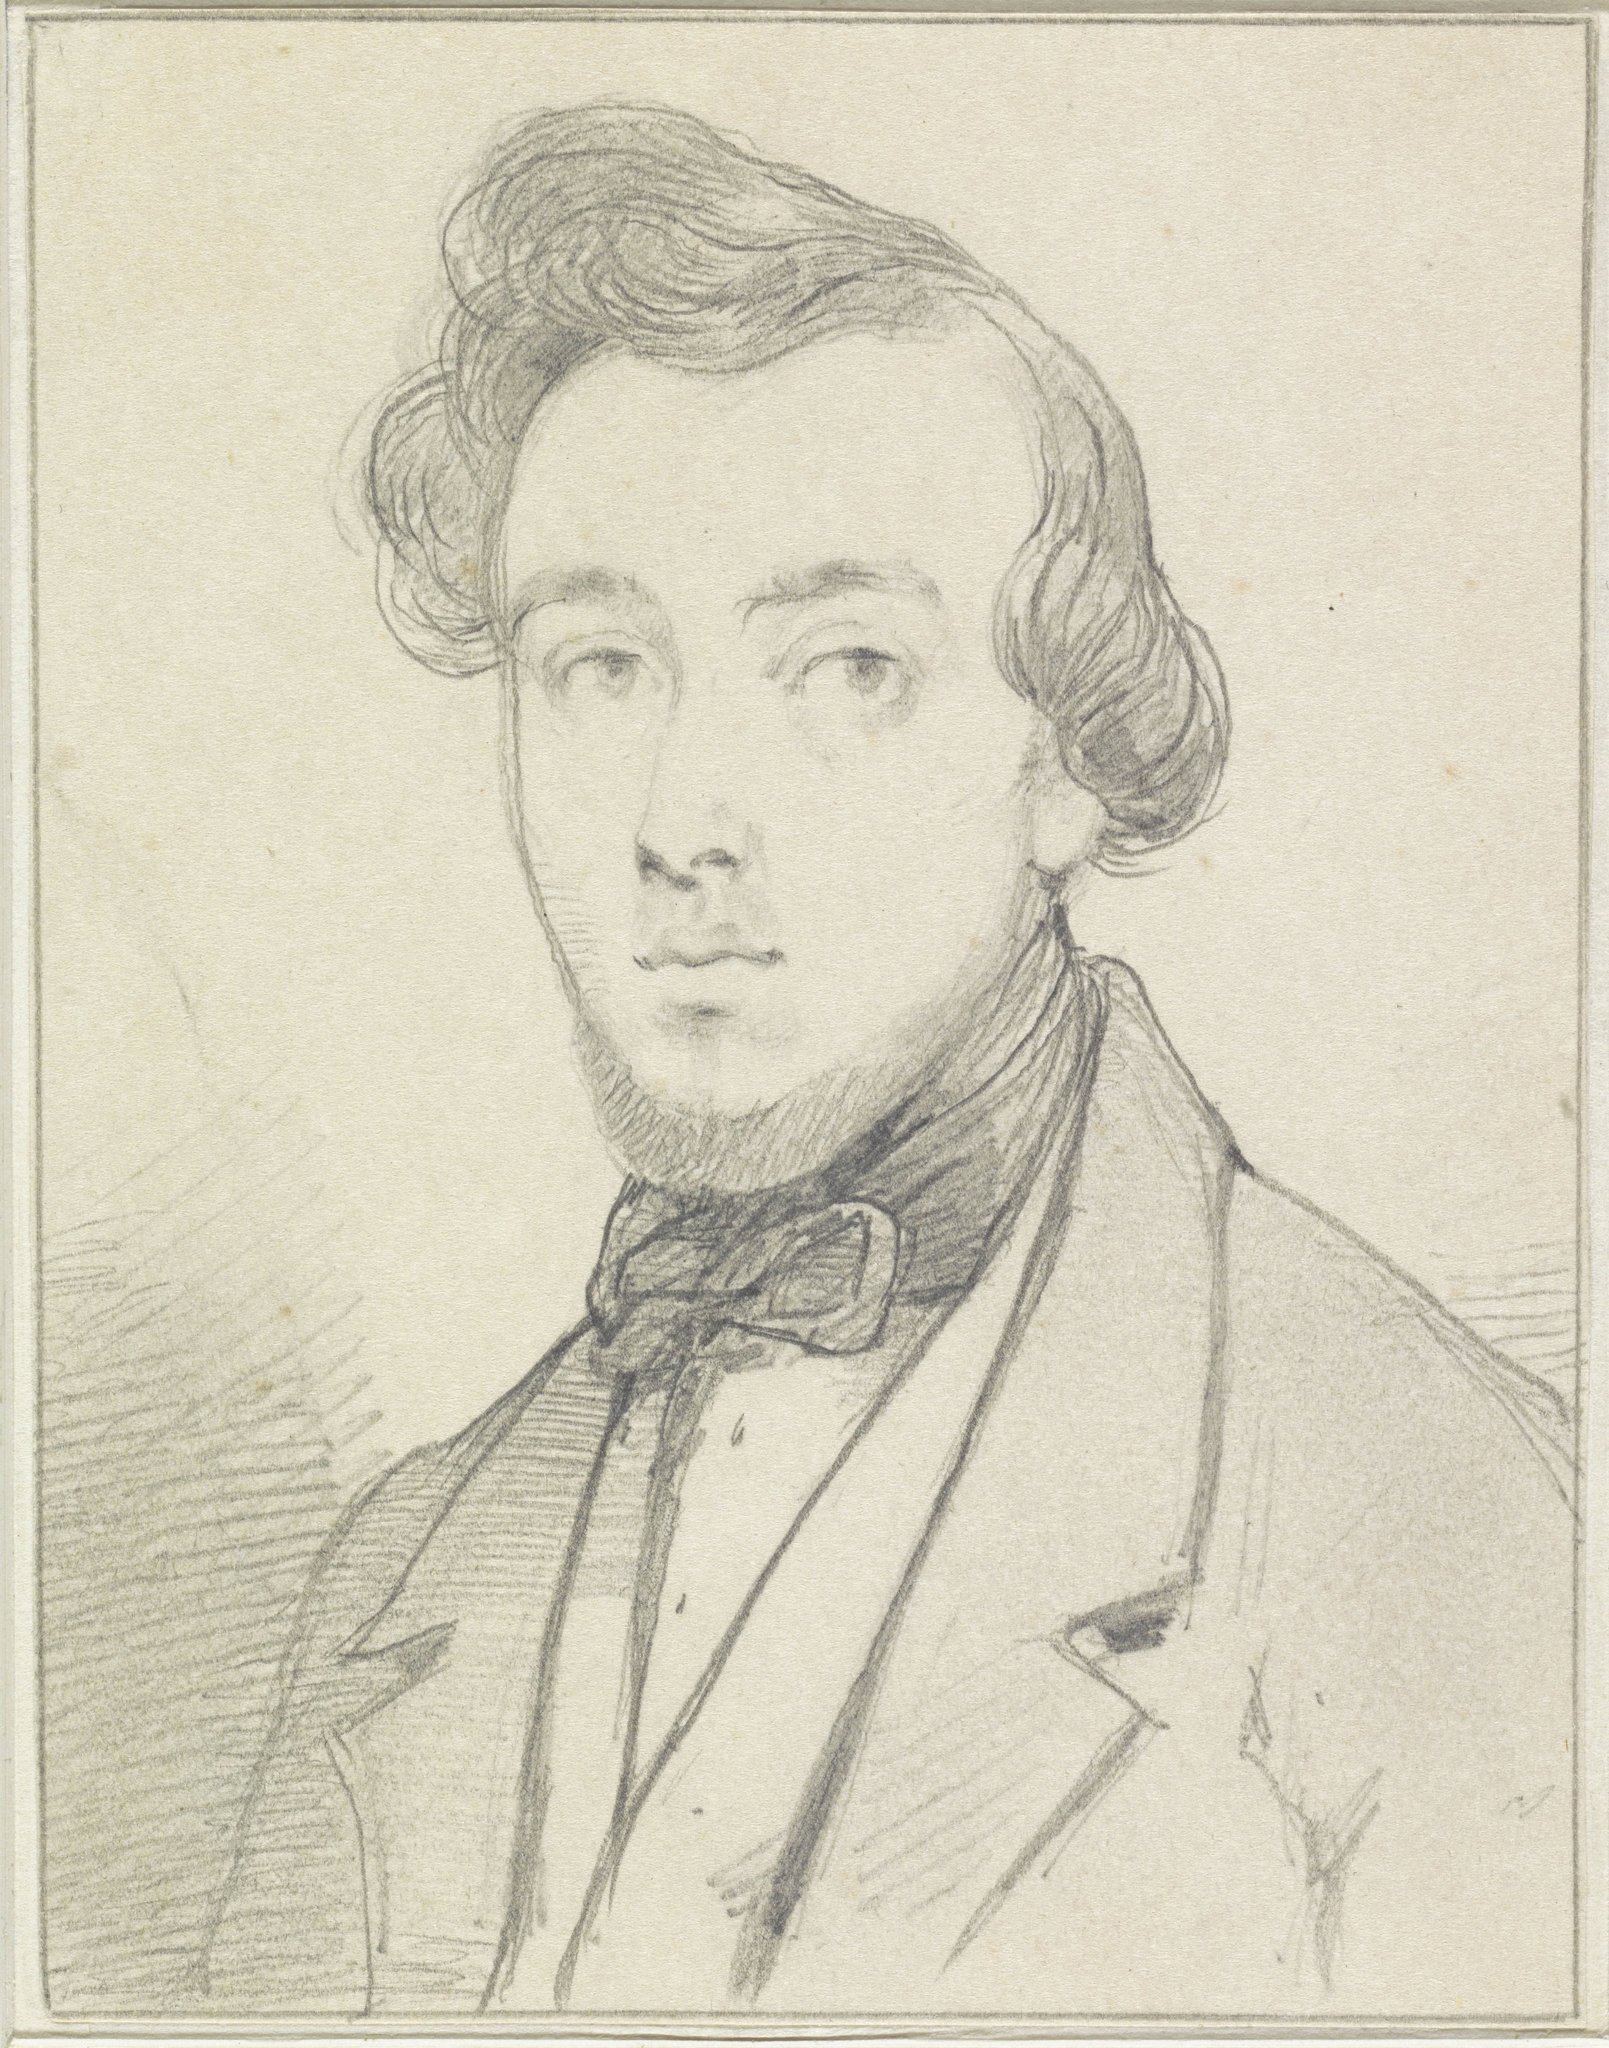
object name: drawing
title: Zelfportret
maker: abraham van pelt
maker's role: draughtsman, print maker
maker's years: 1815-1895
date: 1825-1895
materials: paper, pencil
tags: nijmegen, print maker, draughtsman, abraham van pelt, historical persons, portrait, self-portrait of artist